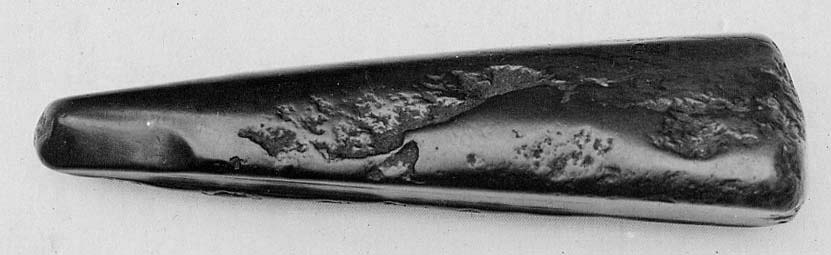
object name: hand pestle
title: Hand-pestle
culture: north american, alaskan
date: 1902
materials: jade